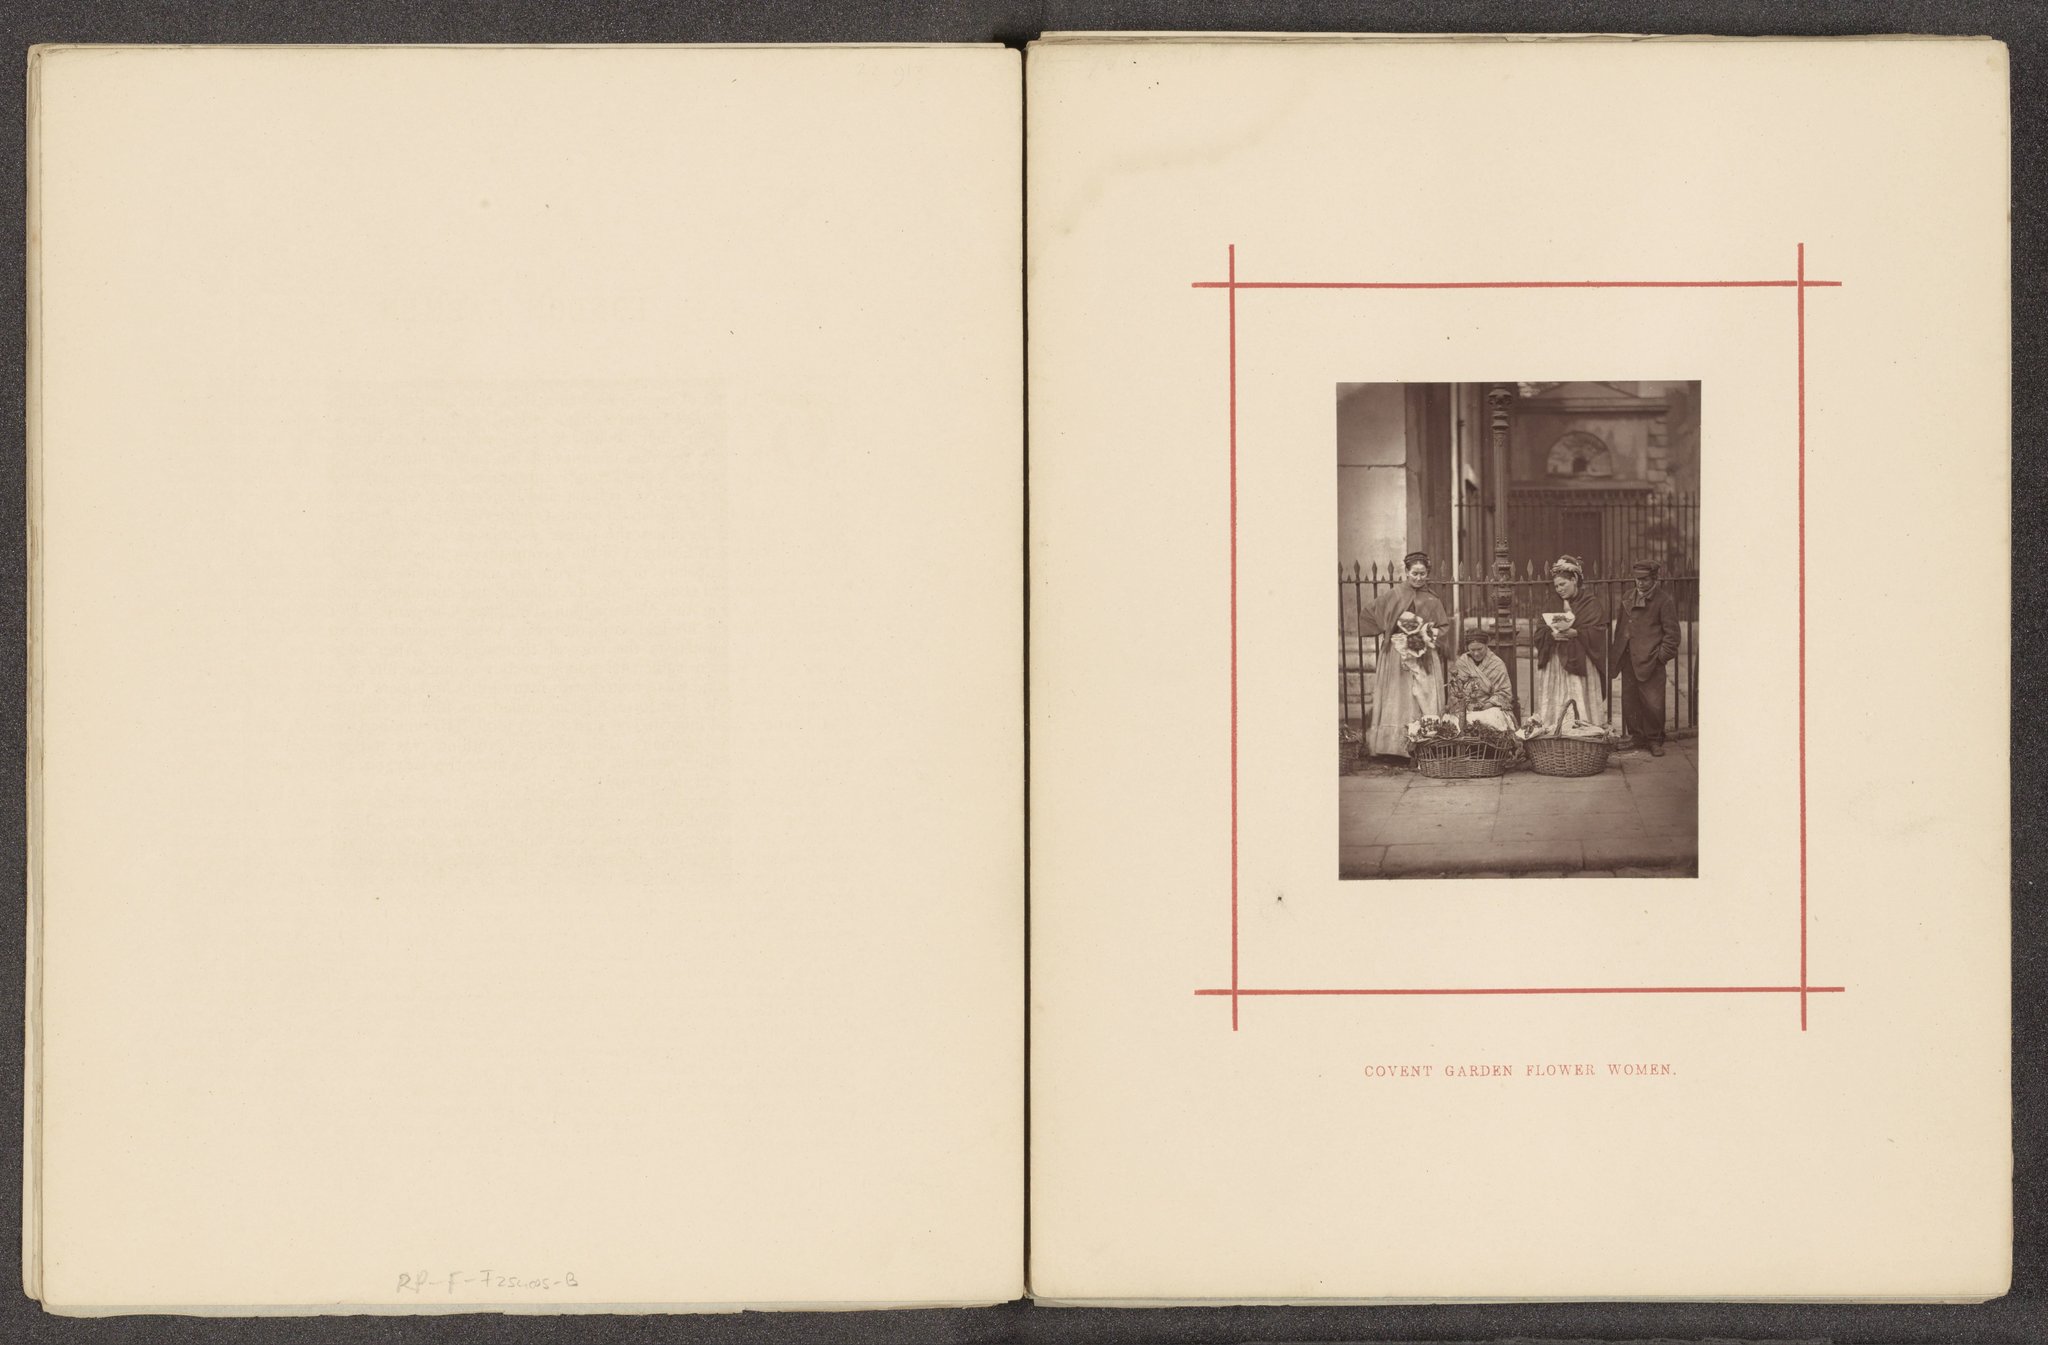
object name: page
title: Covent Garden Flower Women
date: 1876-1877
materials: paper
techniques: woodburytype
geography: covent garden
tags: street-trader